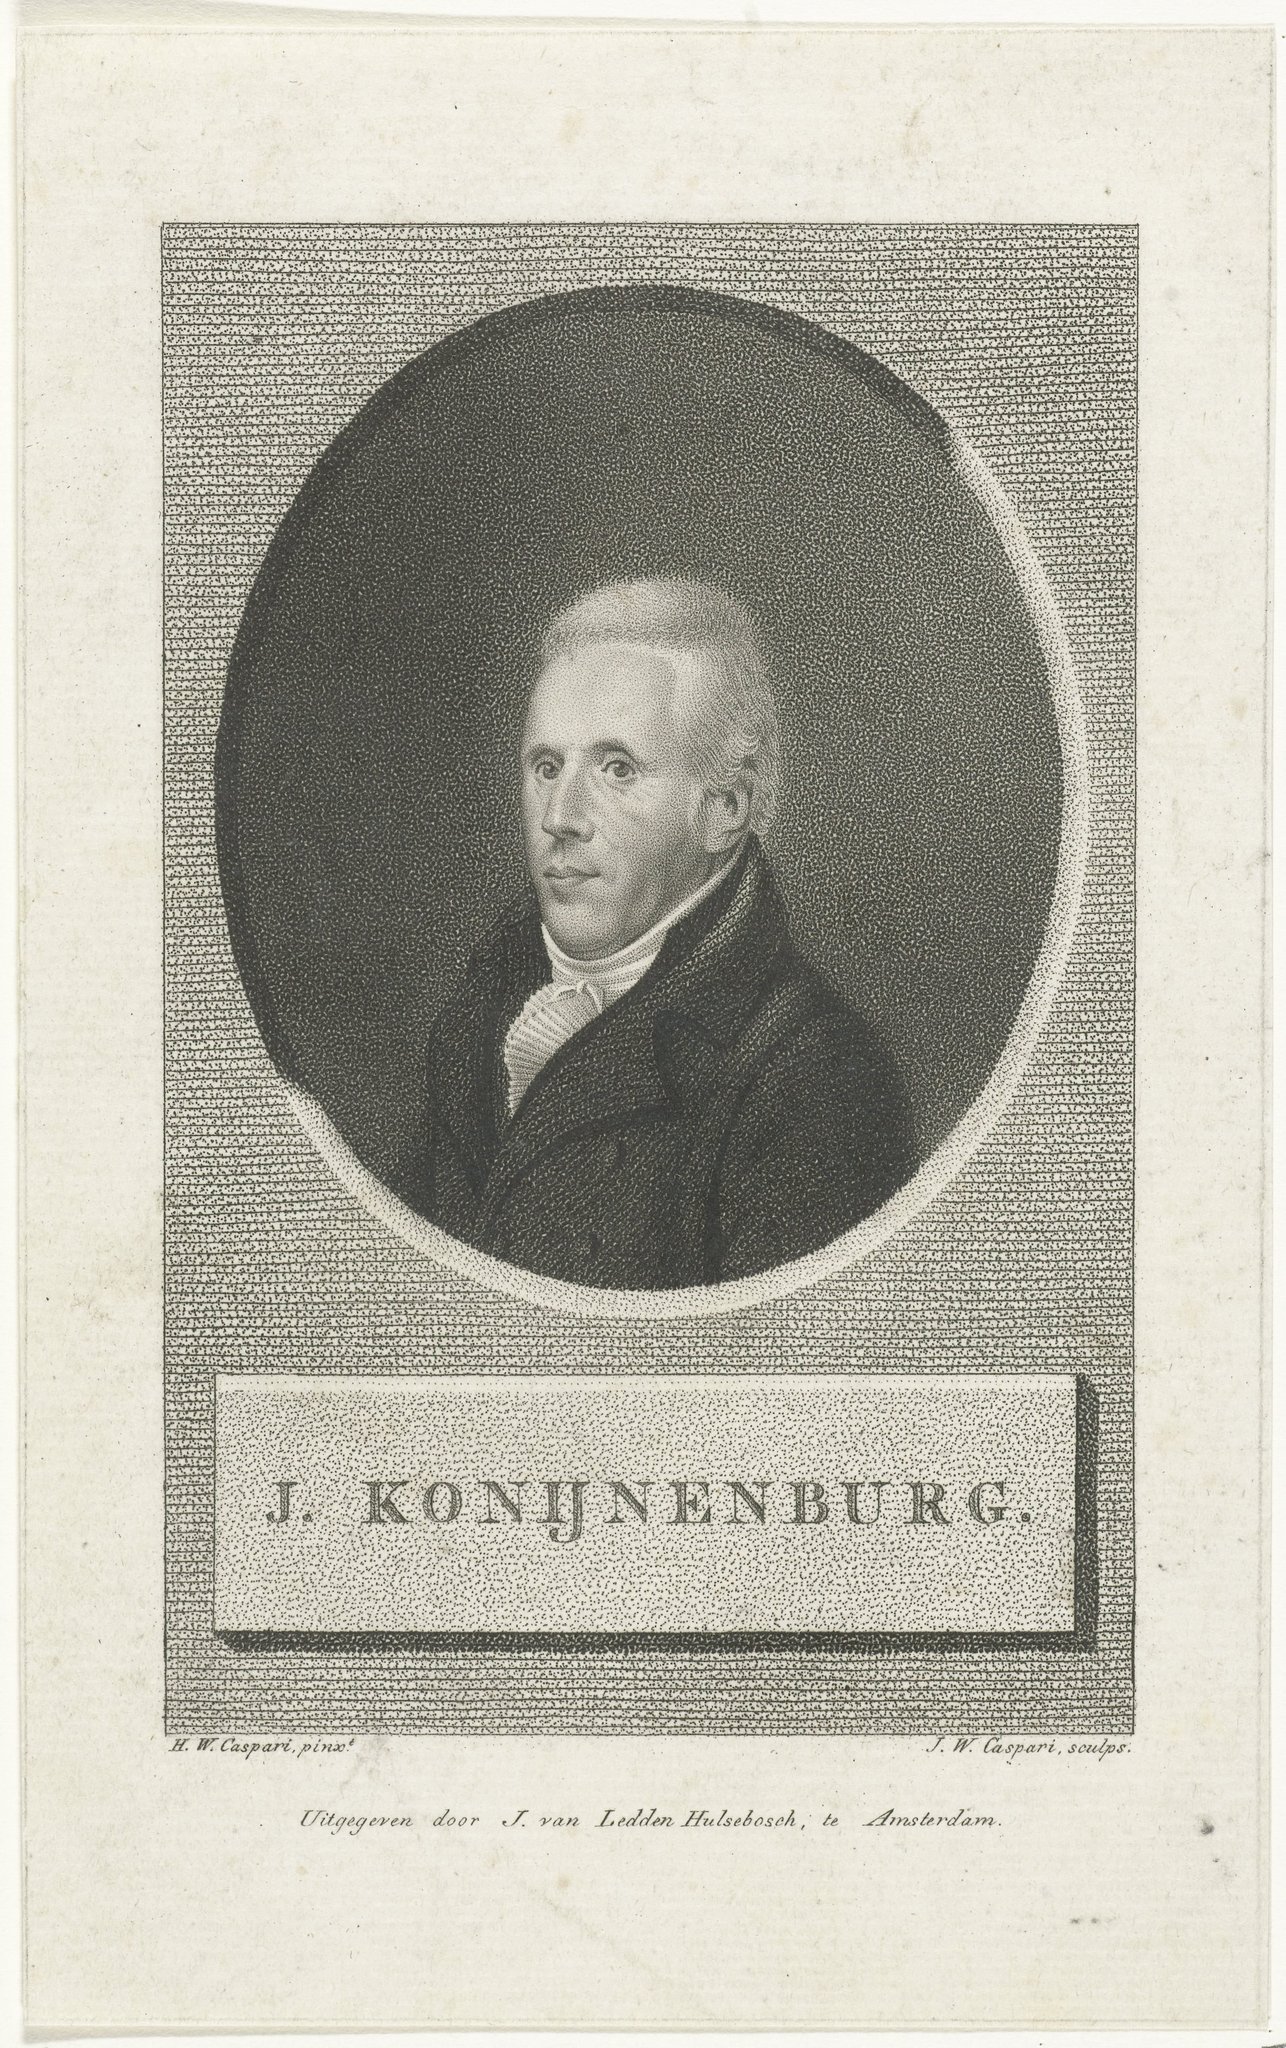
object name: print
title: Portret van Jan Konijnenburg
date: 1789-1822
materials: paper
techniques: etching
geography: amsterdam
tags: amsterdam, jan konijnenburg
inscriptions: collector's mark: Lugt 2228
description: Rond portret van Jan Konijnenburg, predikant en hoogleraar aan het Remonstrants Seminarium in Amsterdam. Buste naar links. Konijnenburg heeft een zwarte jas aan met een hoge kraag. De prent heeft een onderschrift met naam geportretteerde.